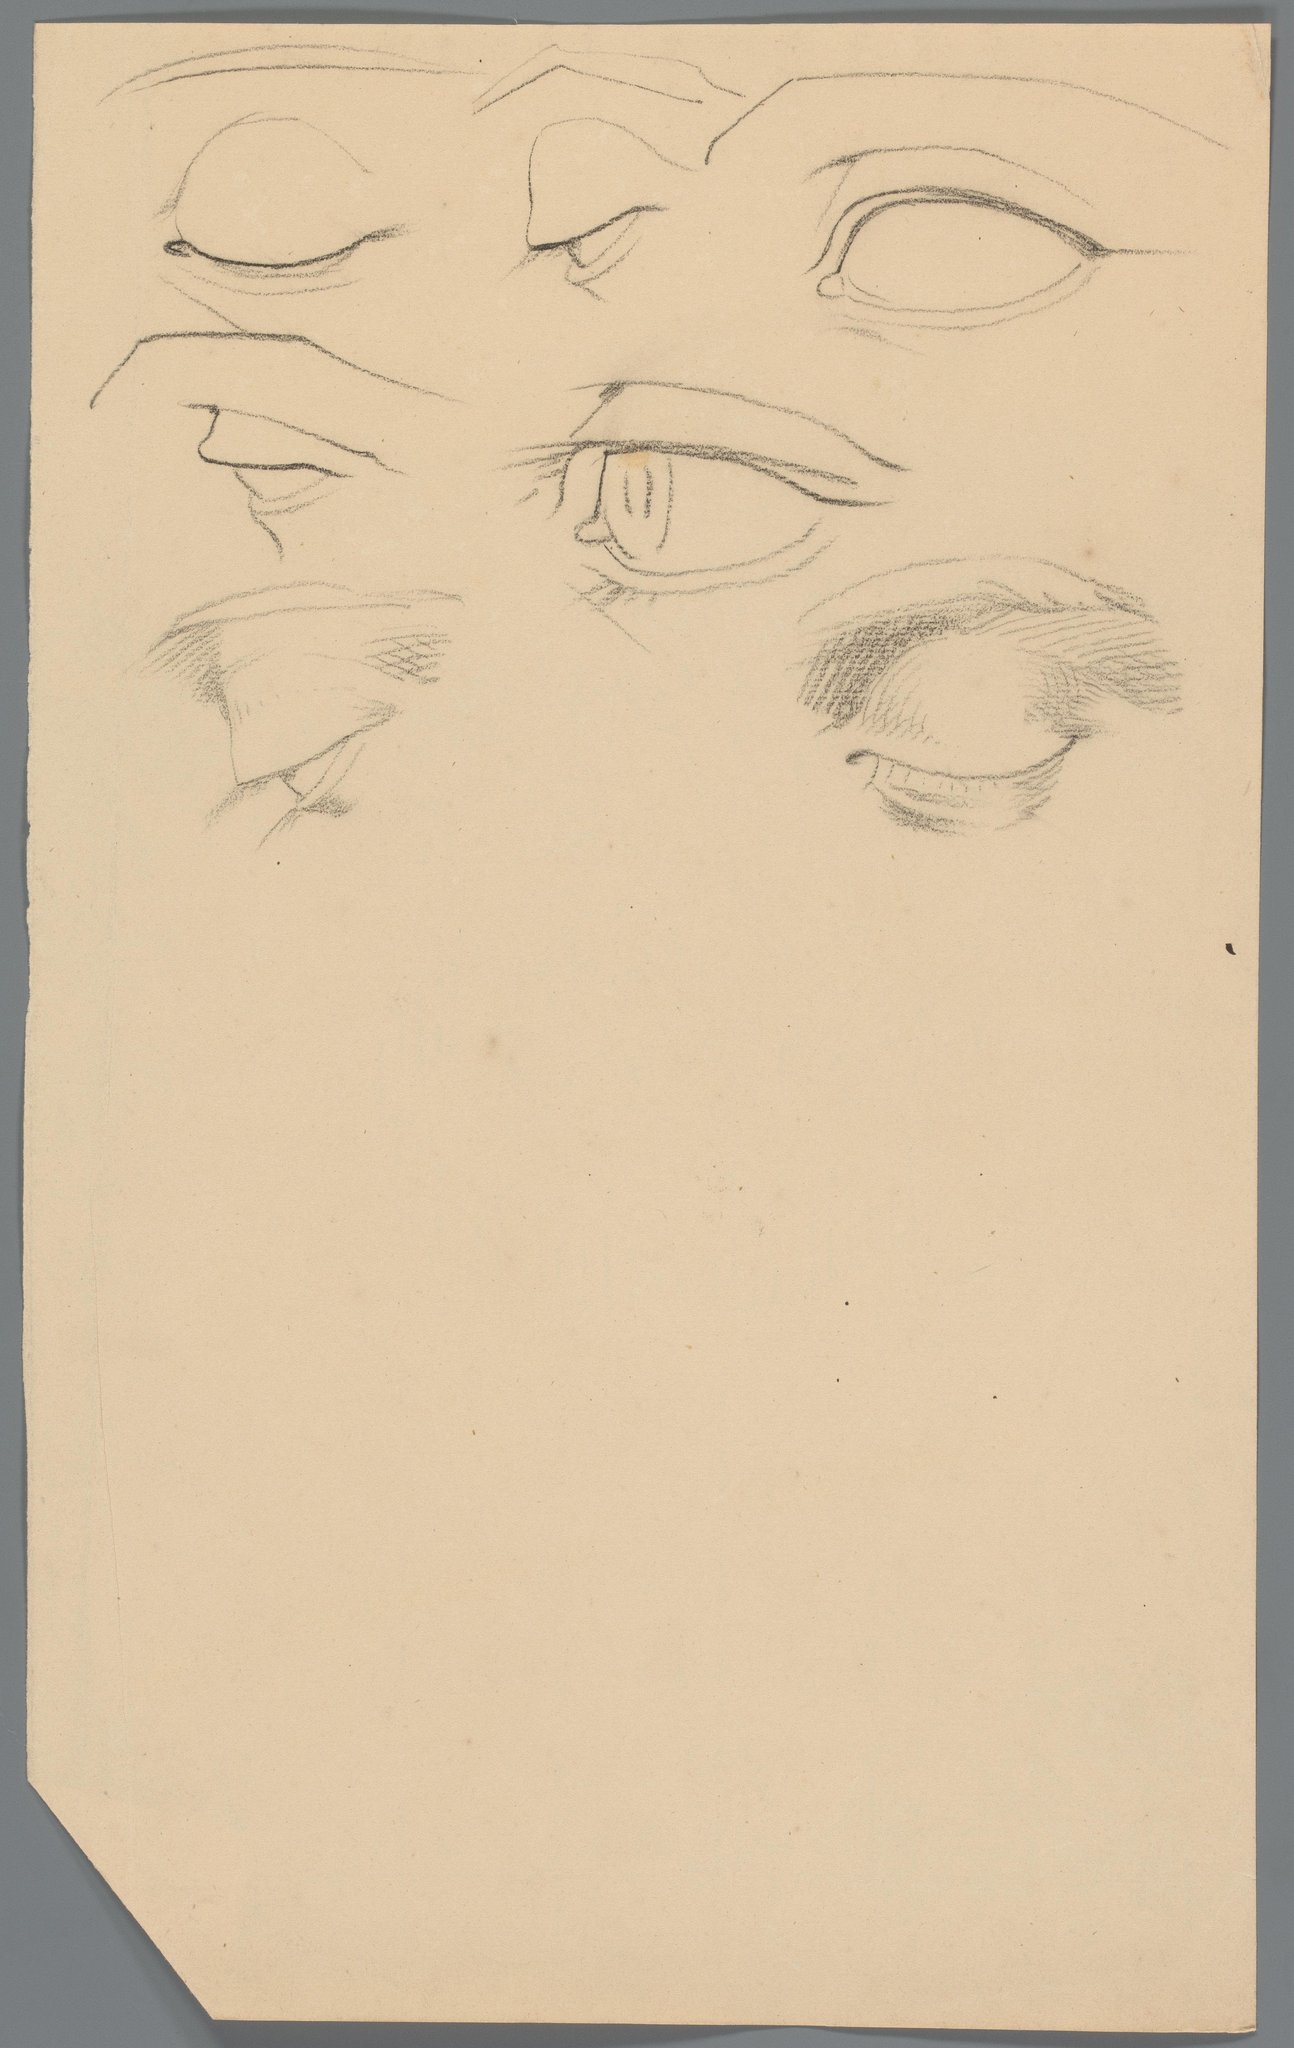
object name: drawing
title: Studieblad met ogen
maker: jacobus everhardus josephus van den berg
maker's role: draughtsman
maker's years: 1802-1861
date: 1812-1861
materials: chalk, paper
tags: eyes